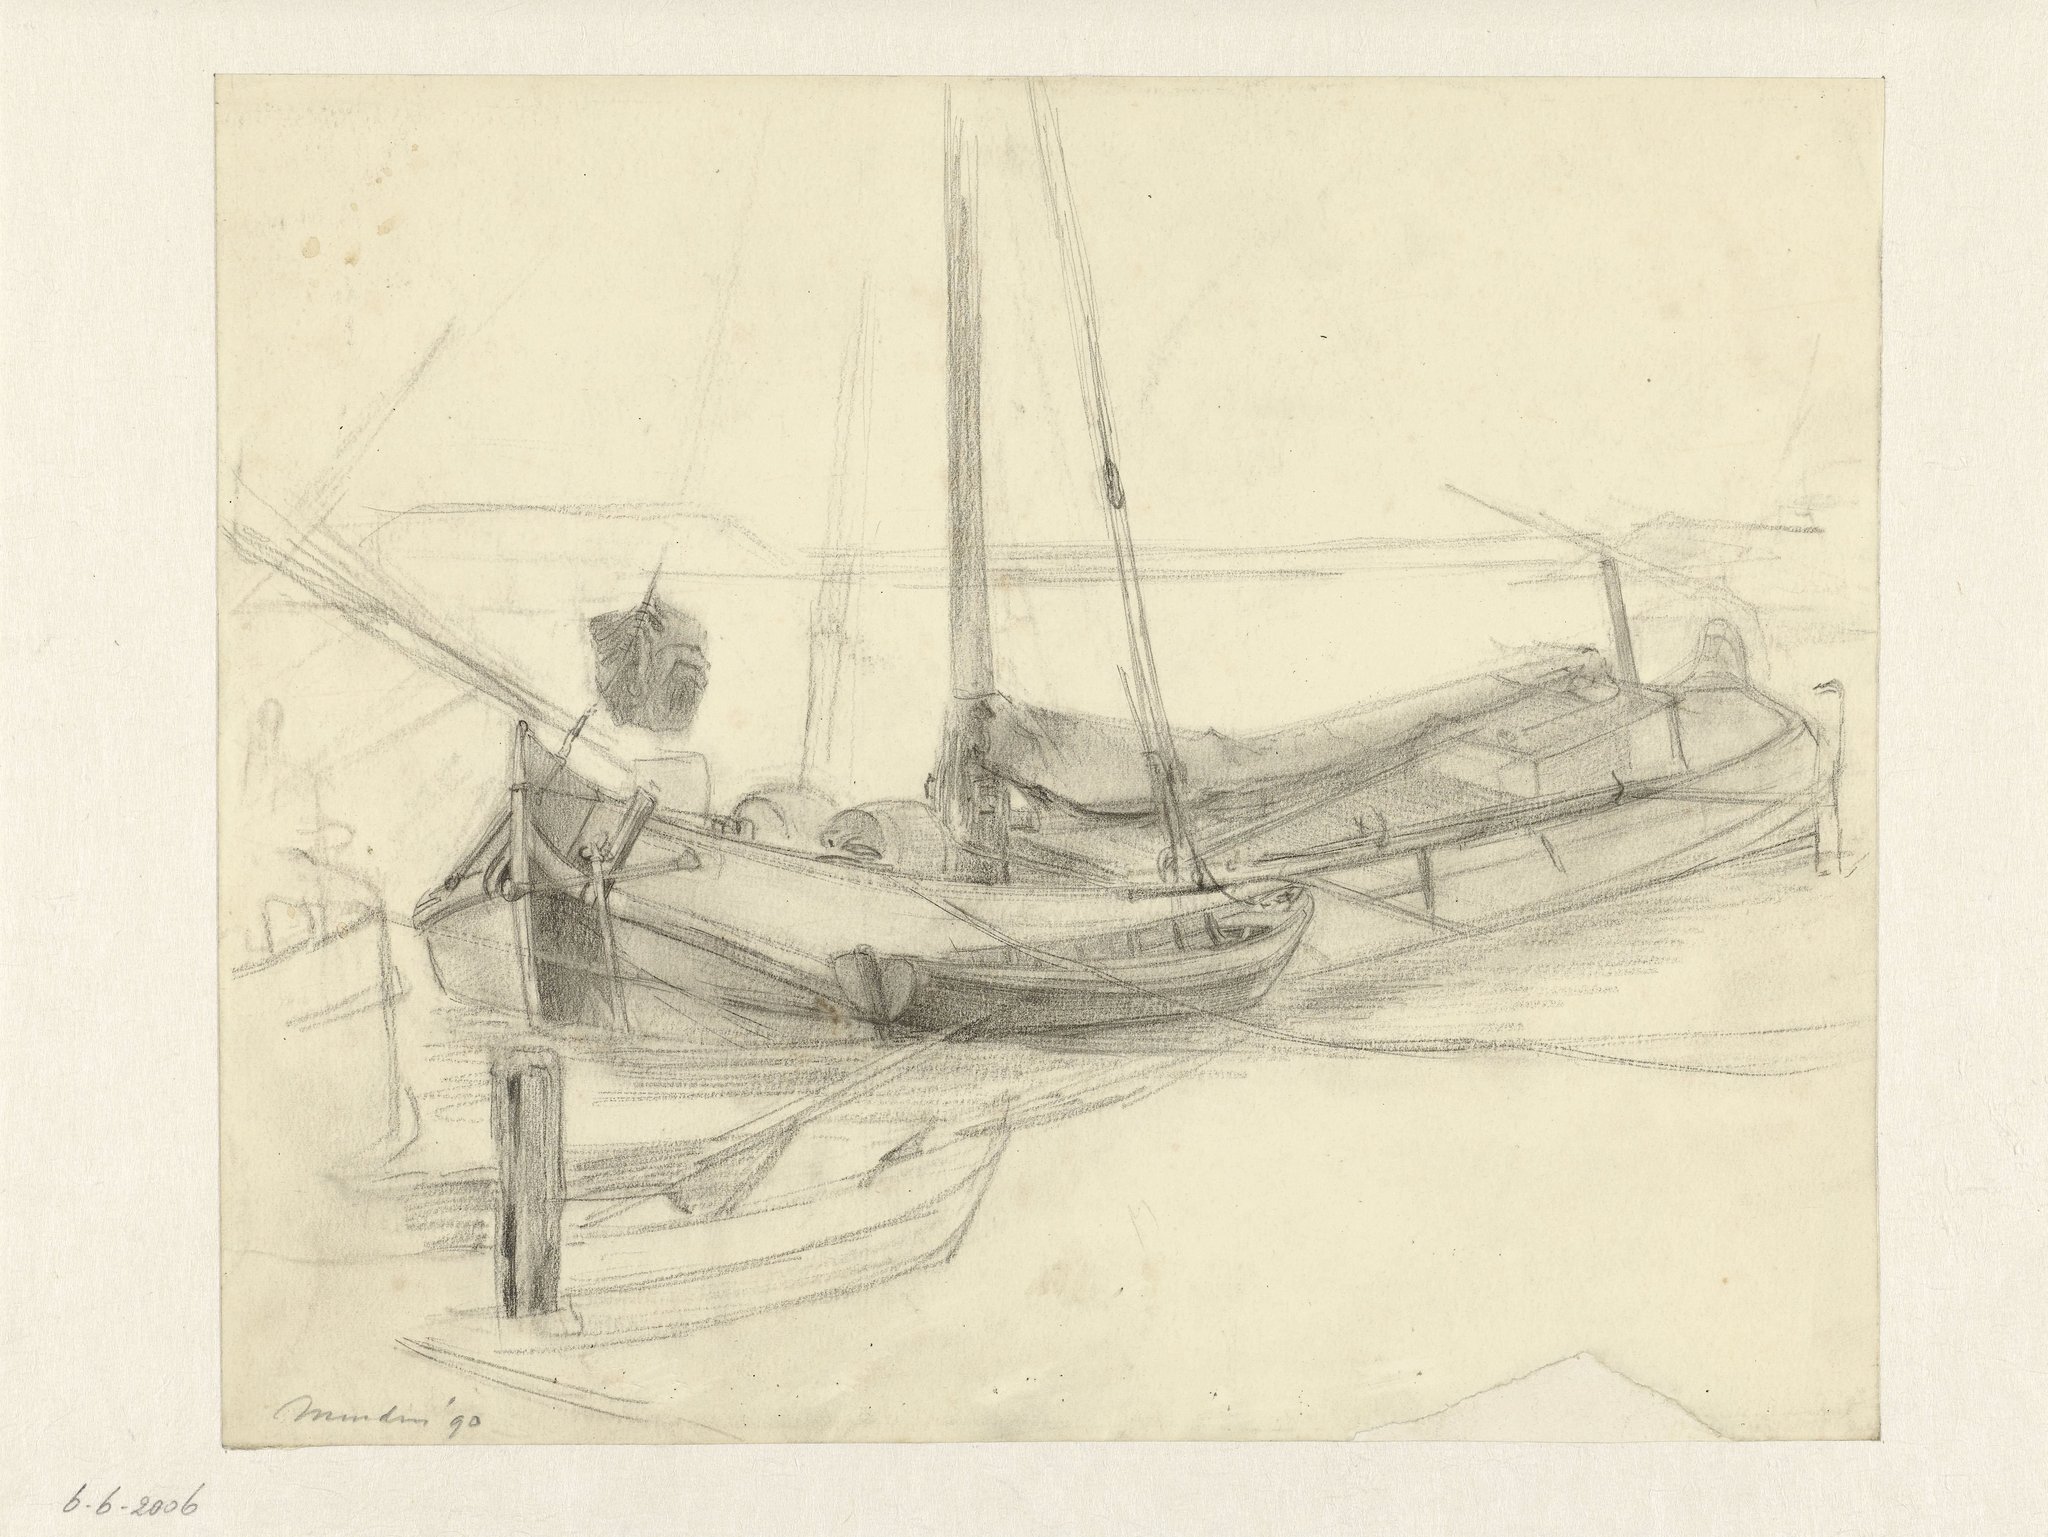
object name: drawing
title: Tjalk en roeiboten in de haven van Muiden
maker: cornelis gerardus t hooft (1791-1871)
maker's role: draughtsman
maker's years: 1791-1871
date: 1890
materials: chalk, paper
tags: harbour, sailing-ship, sailing-boat, rowing-boat, canoe, etc.